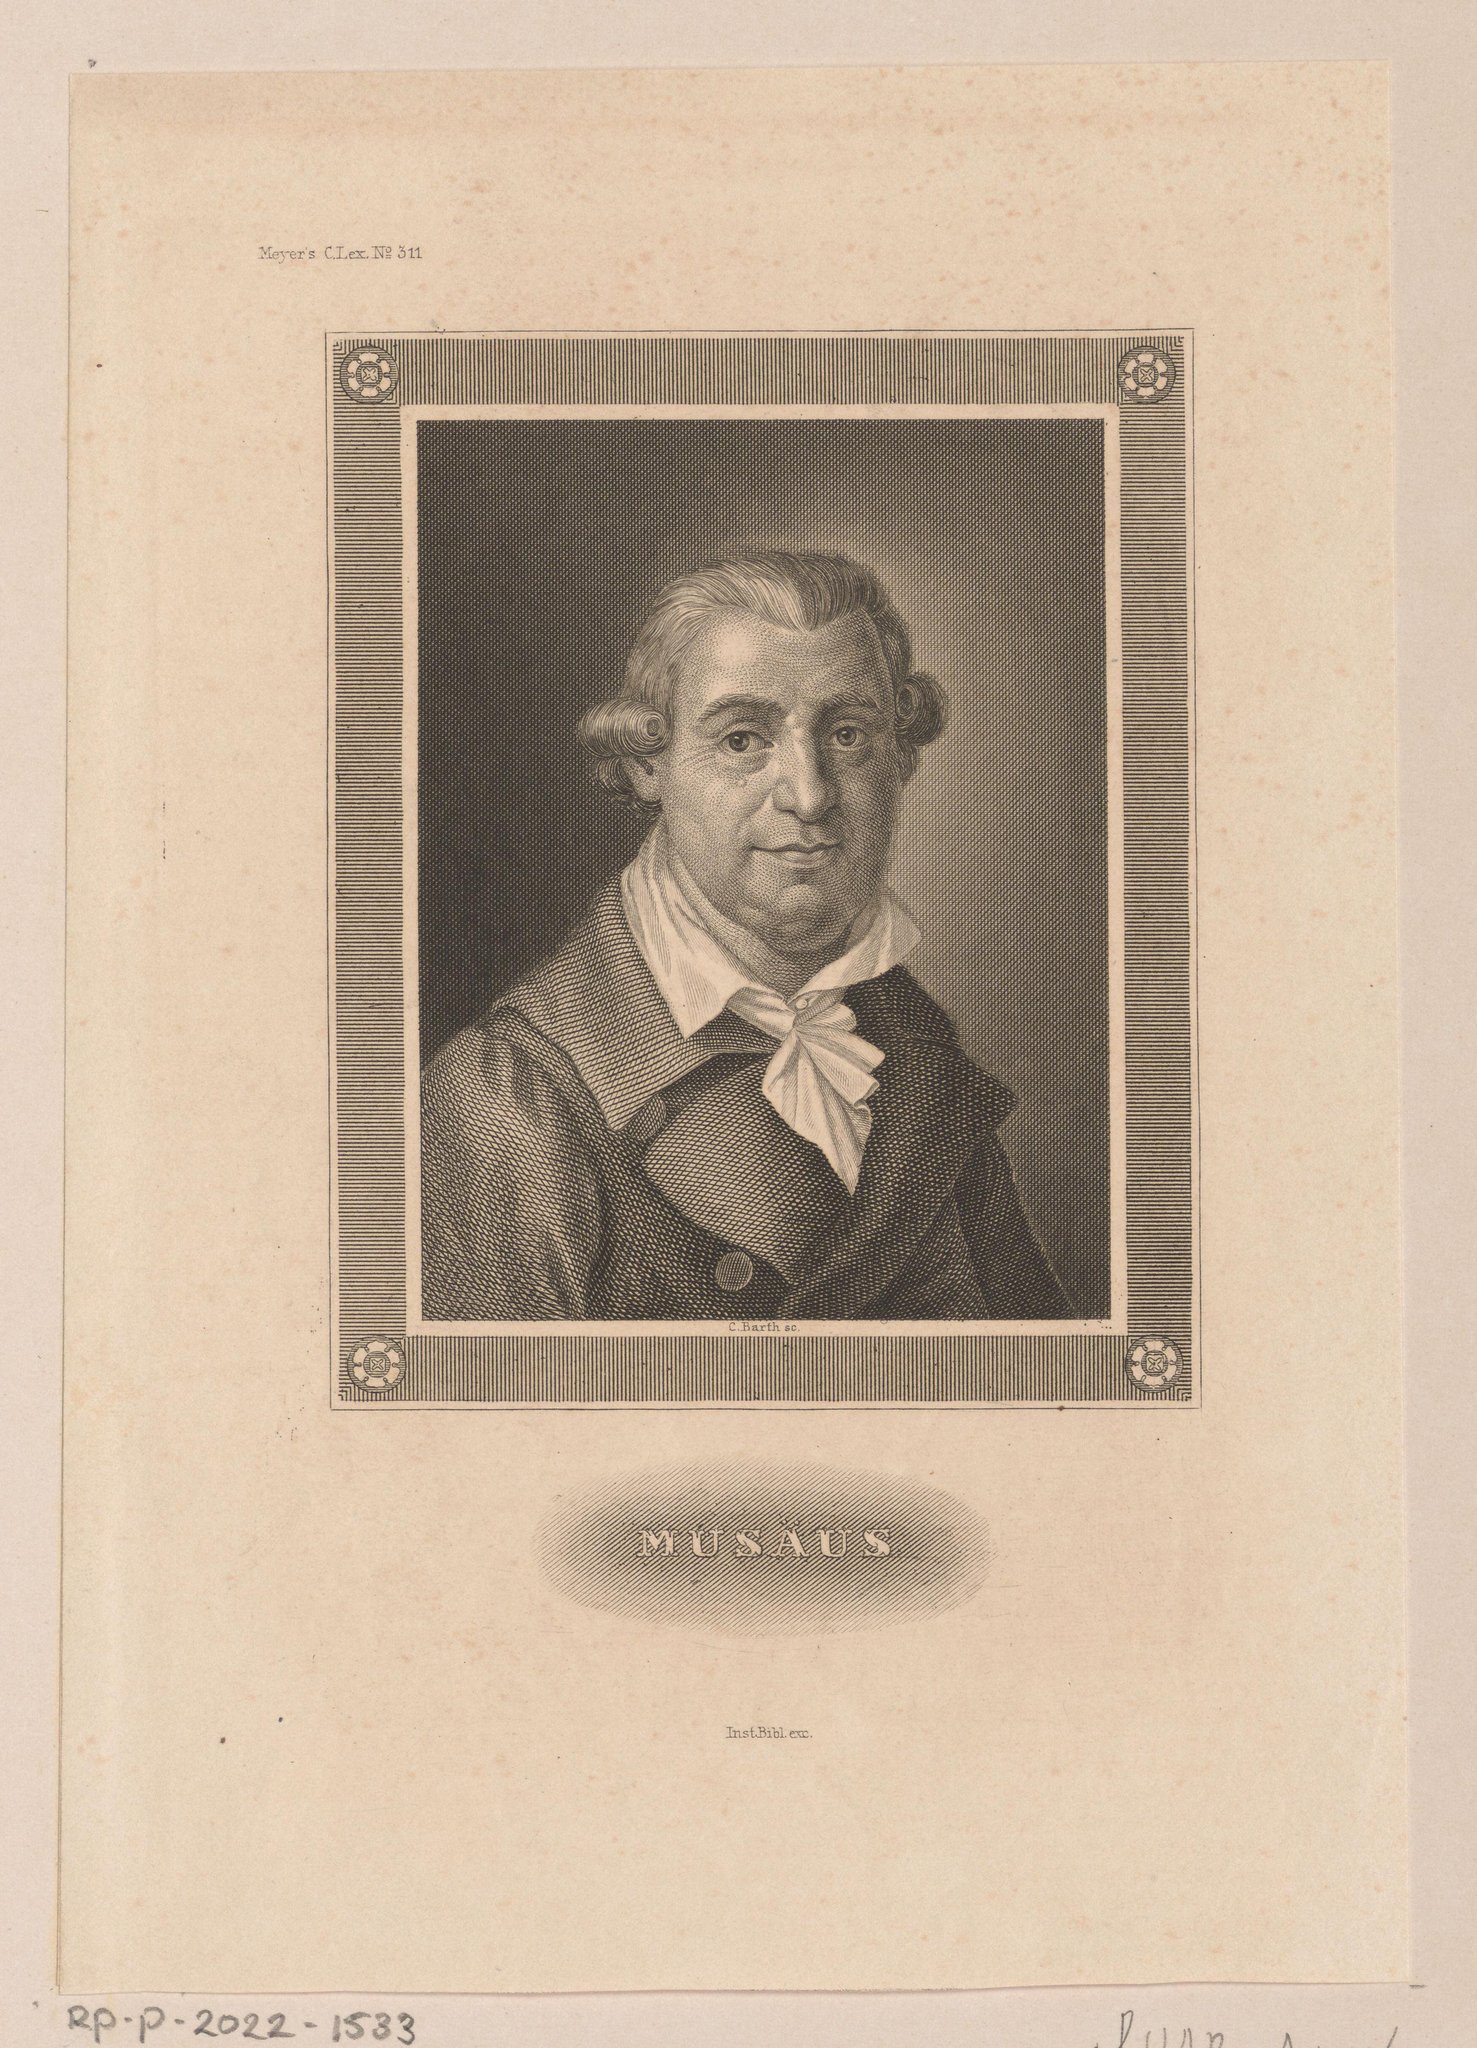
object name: print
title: Portret van Johann Carl August Musäus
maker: Anonymous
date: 1826-1874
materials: paper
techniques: engraving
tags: historical persons, writer, poet, author